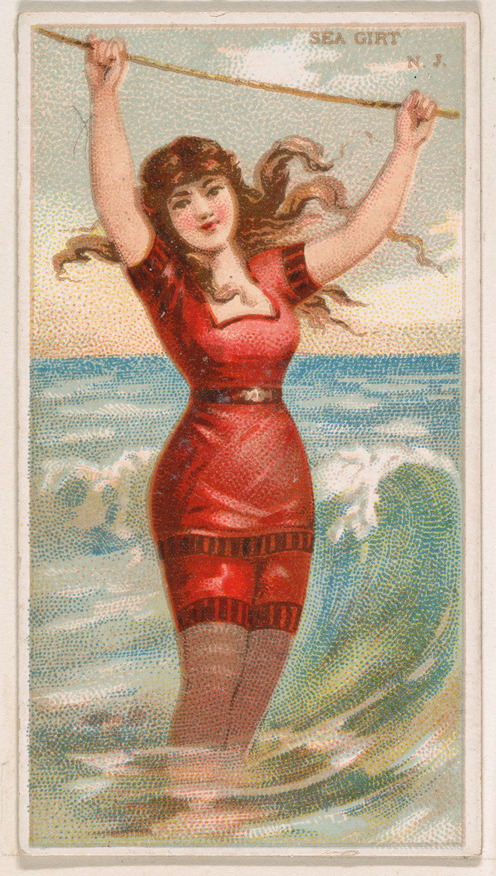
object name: print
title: Sea Girt, New Jersey, from the Surf Beauties series (N232), issued by Kinney Bros.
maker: kinney brothers tobacco company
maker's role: publisher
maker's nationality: american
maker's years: 1869-2011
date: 1889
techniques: color lithograph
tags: women,sports